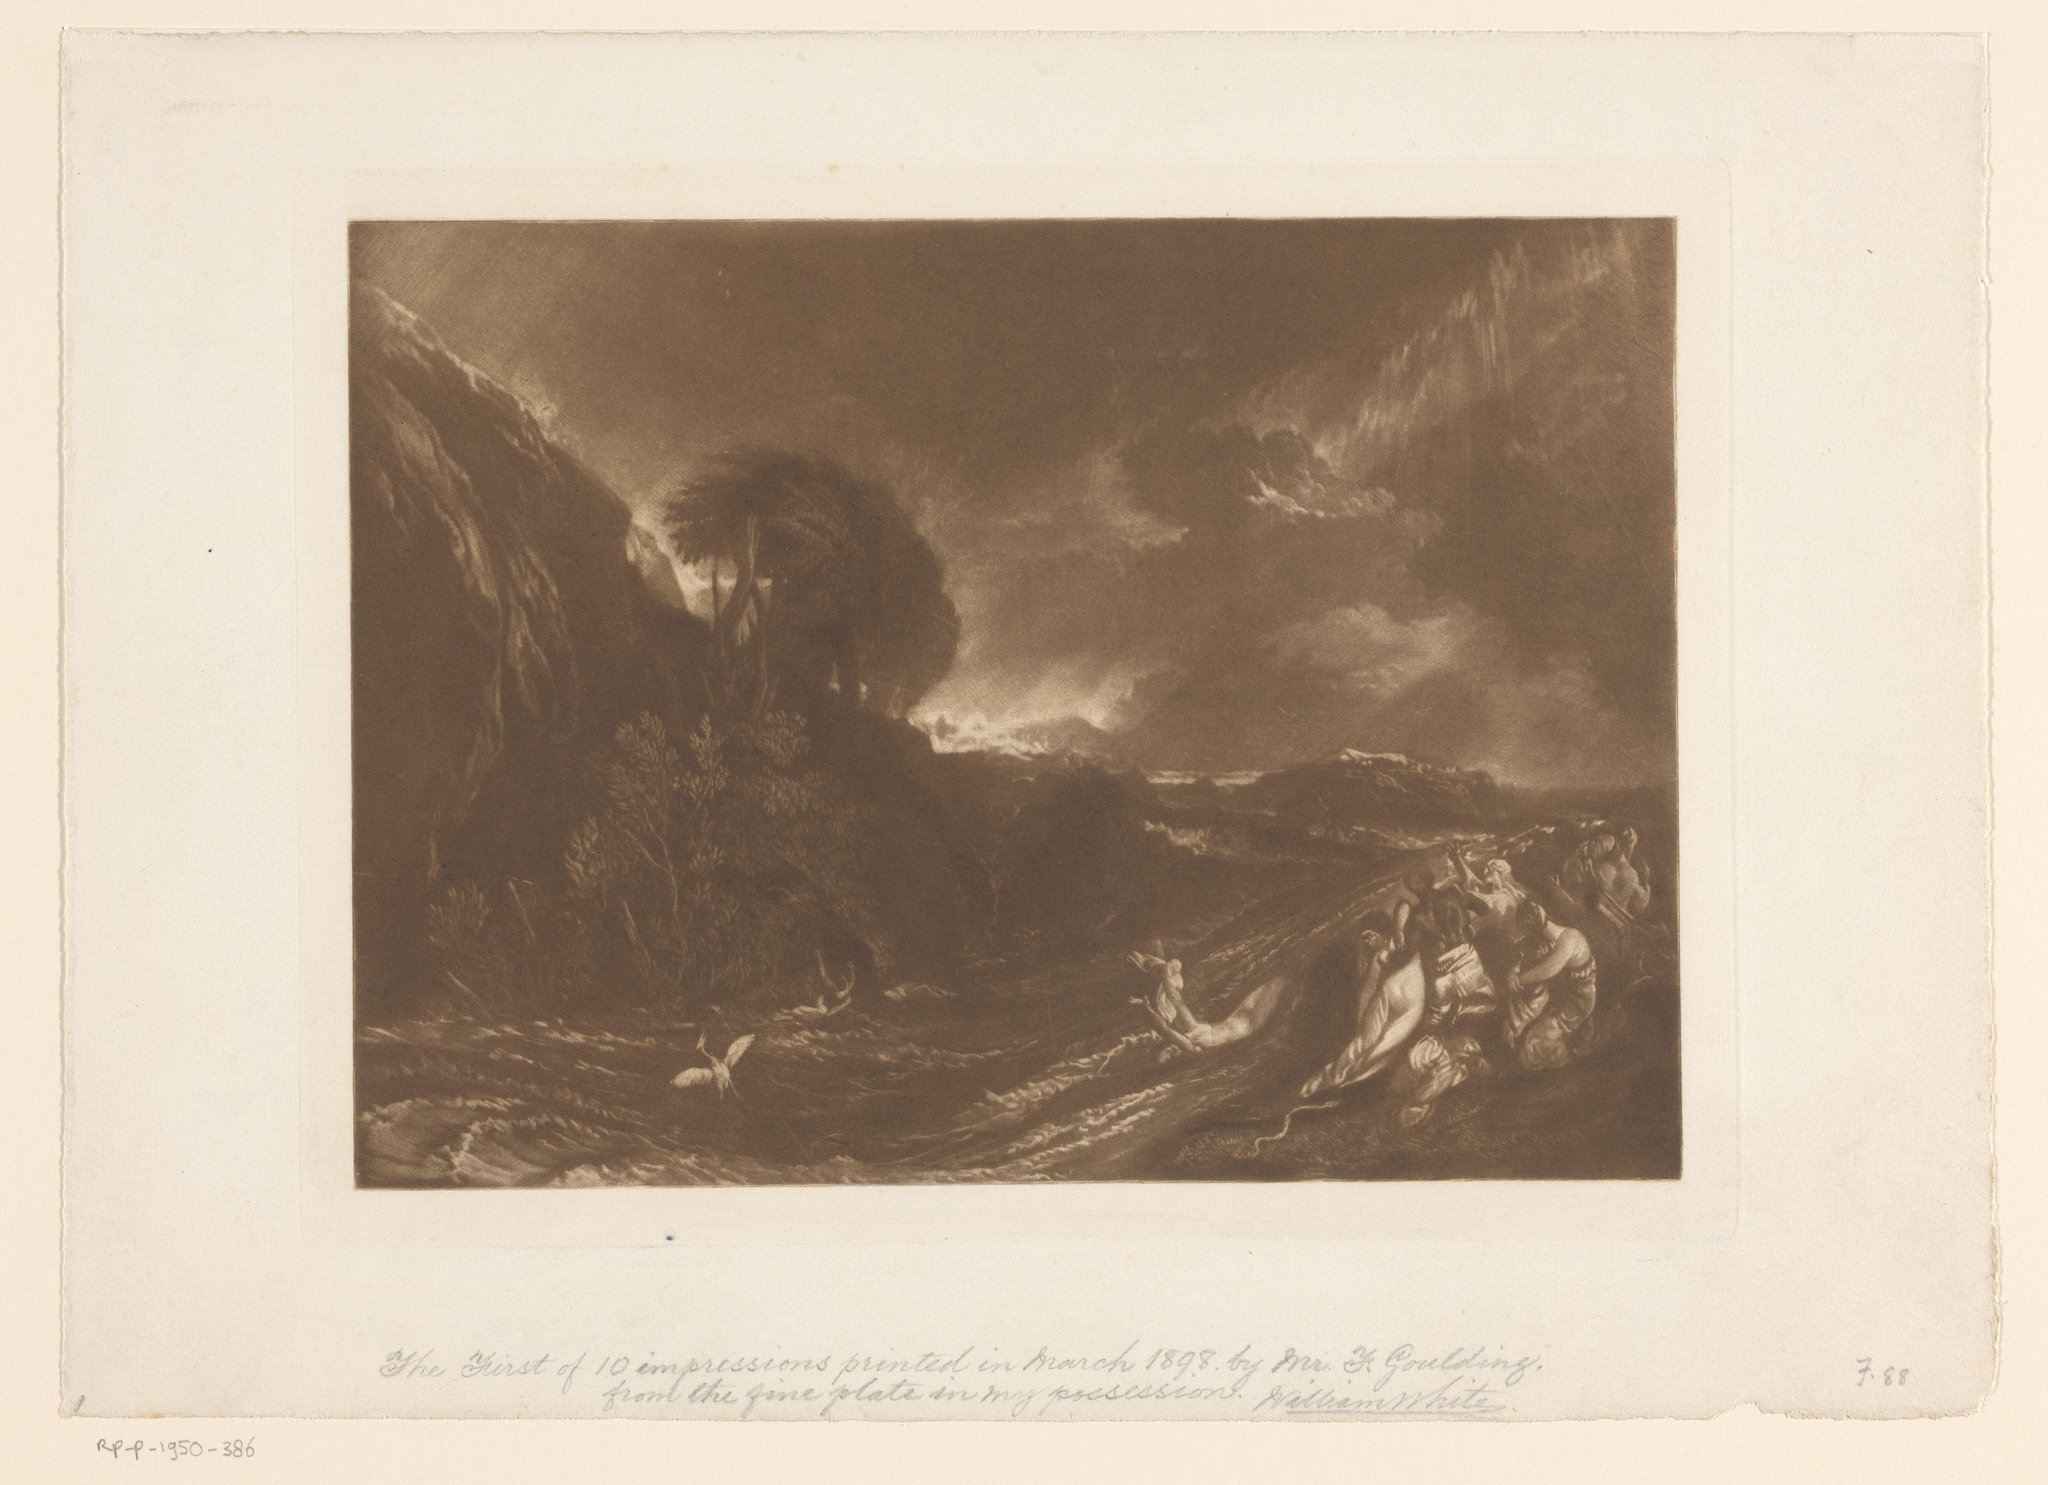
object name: print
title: The Deluge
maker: frederick goulding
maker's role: print maker, printer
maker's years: 1842-1909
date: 1828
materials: paper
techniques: mezzotint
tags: storm, death by drowning (non-violent)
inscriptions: collector's mark: Lugt 2228, inscription: ‘The first of 10 impressions printed in March 1898 by Mr. F. Goulding, from the fine plate in my possession. William White.’